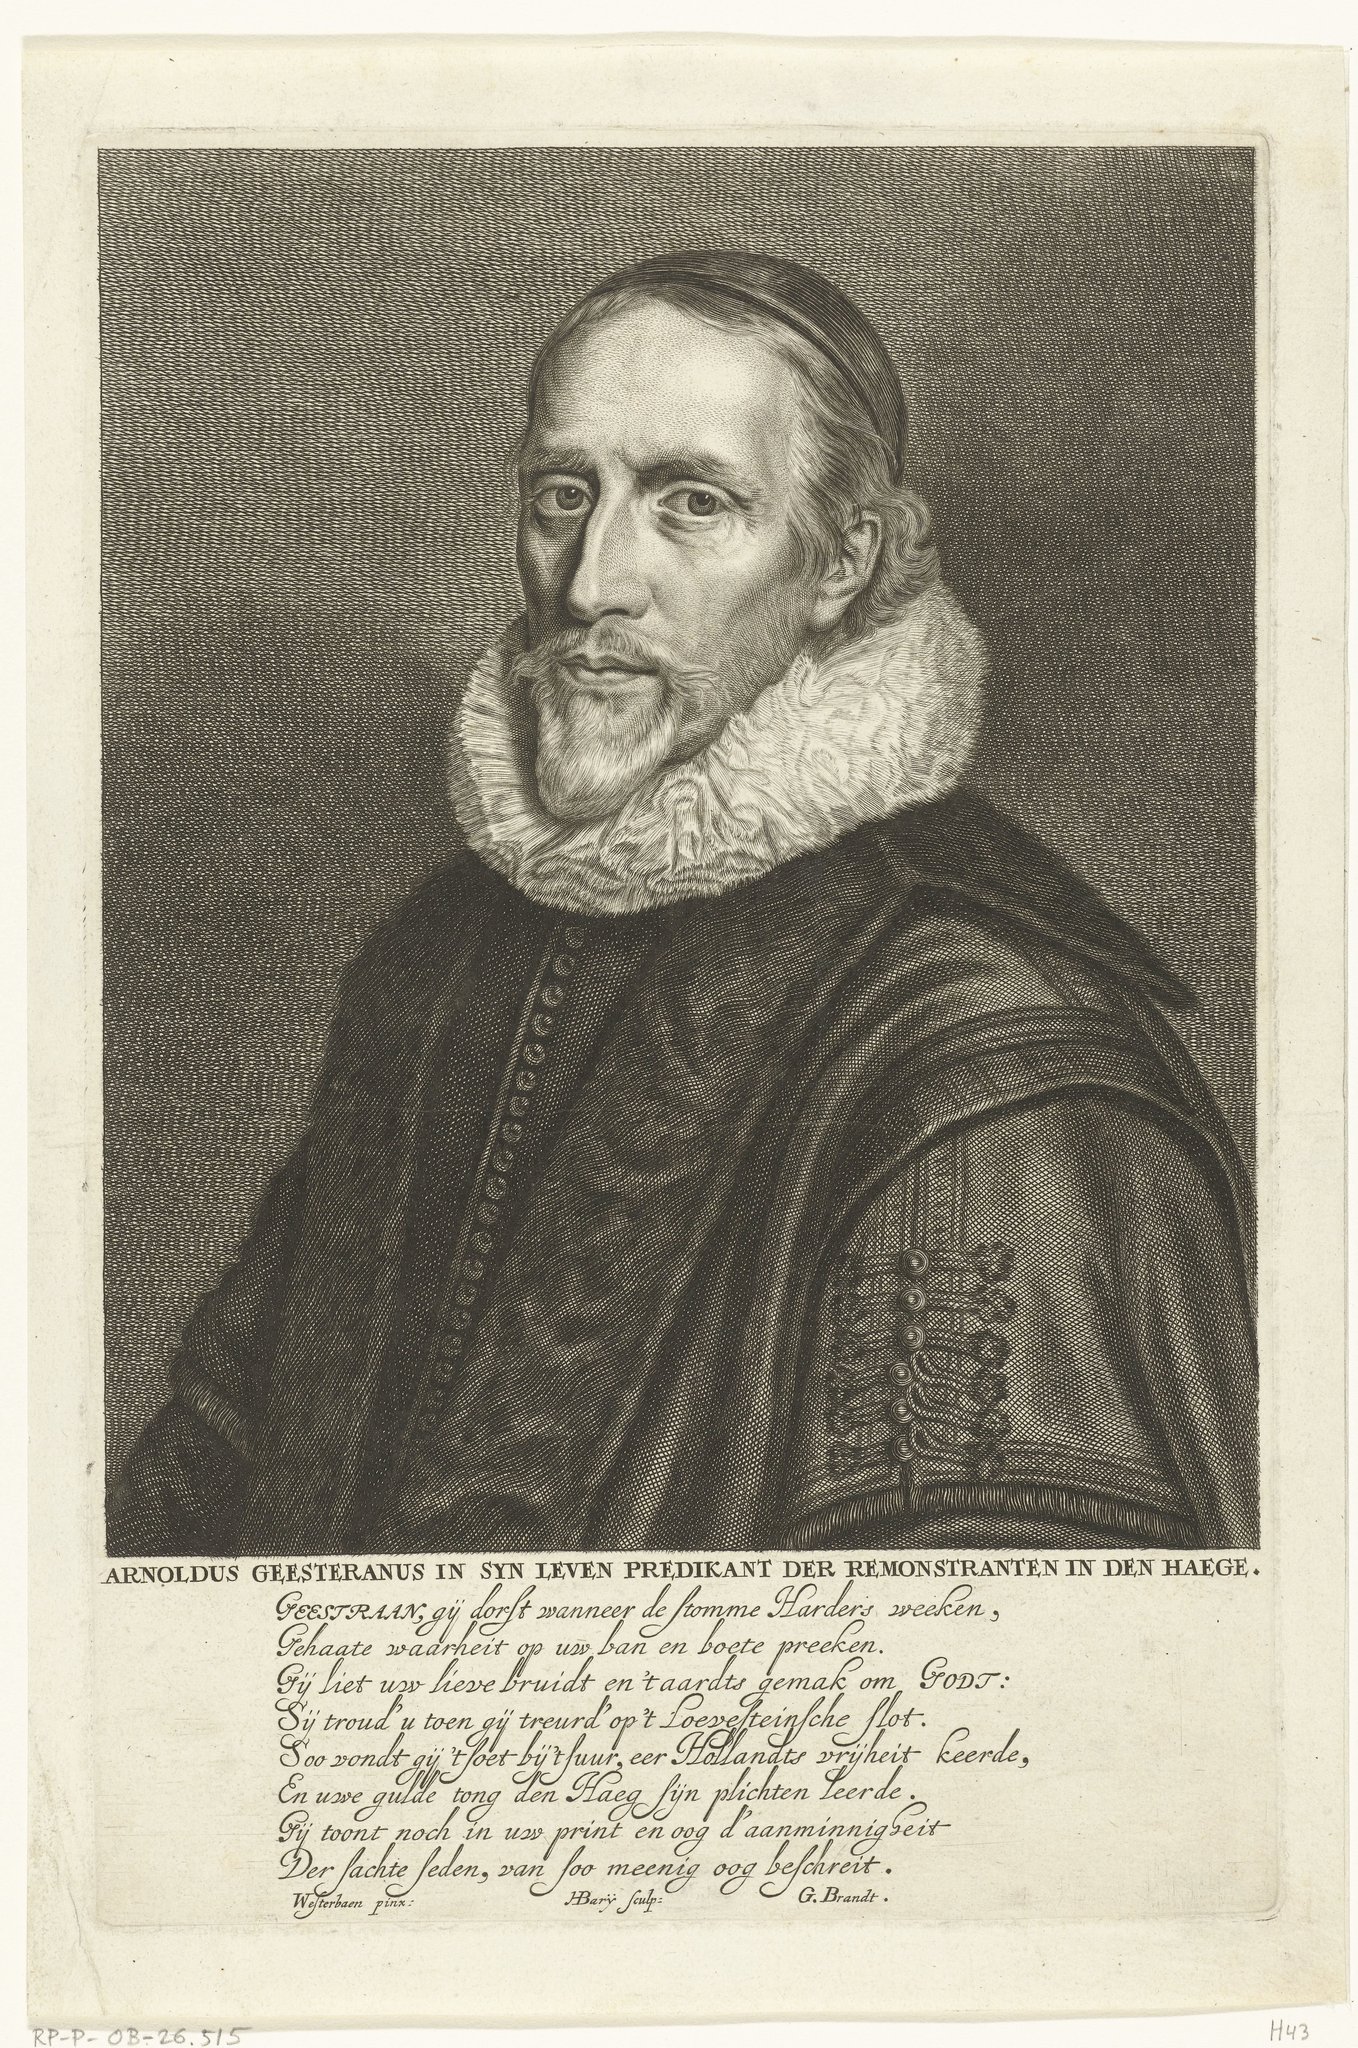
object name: print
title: Portret van Arnoldus Geesteranus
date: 1657-1707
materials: paper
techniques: engraving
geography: netherlands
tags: the hague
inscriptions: collector's mark: Lugt 195, collector's mark: Lugt 2228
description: Borstbeeld van Arnoldus Geesteranus, onder het portret zijn naam en functie en een gedicht van acht regels in het Nederlands.